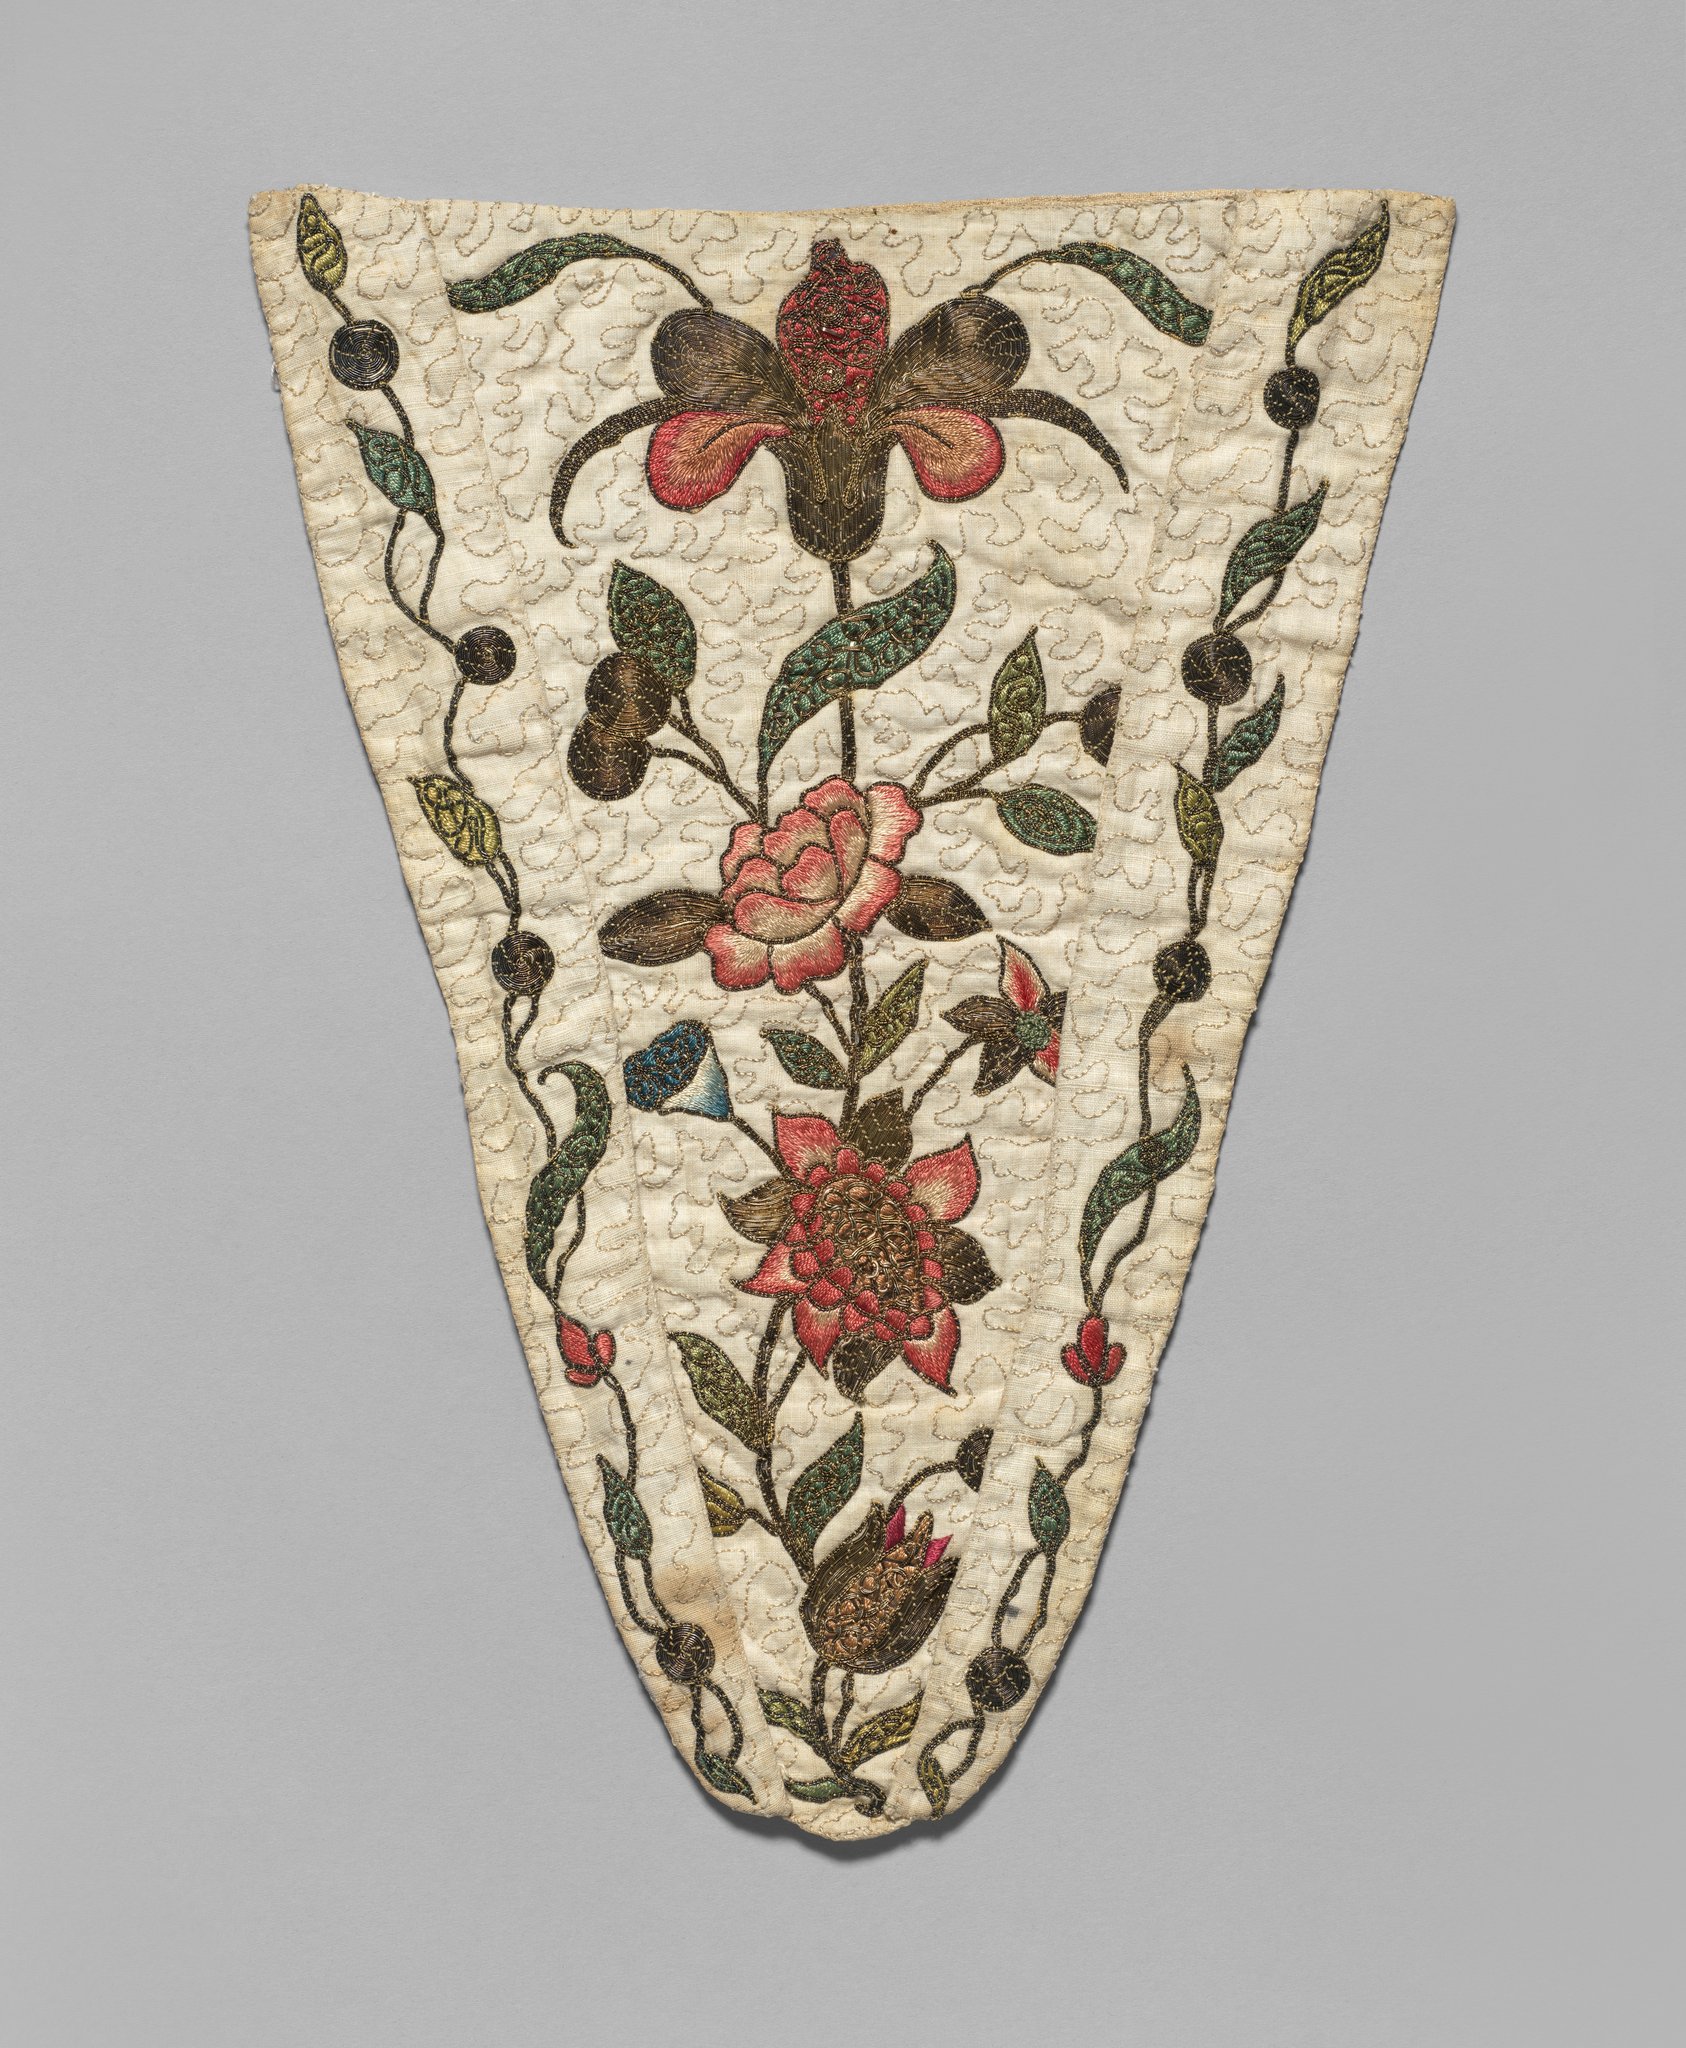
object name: stomacher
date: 1710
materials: linen, silk, thread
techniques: embroidery